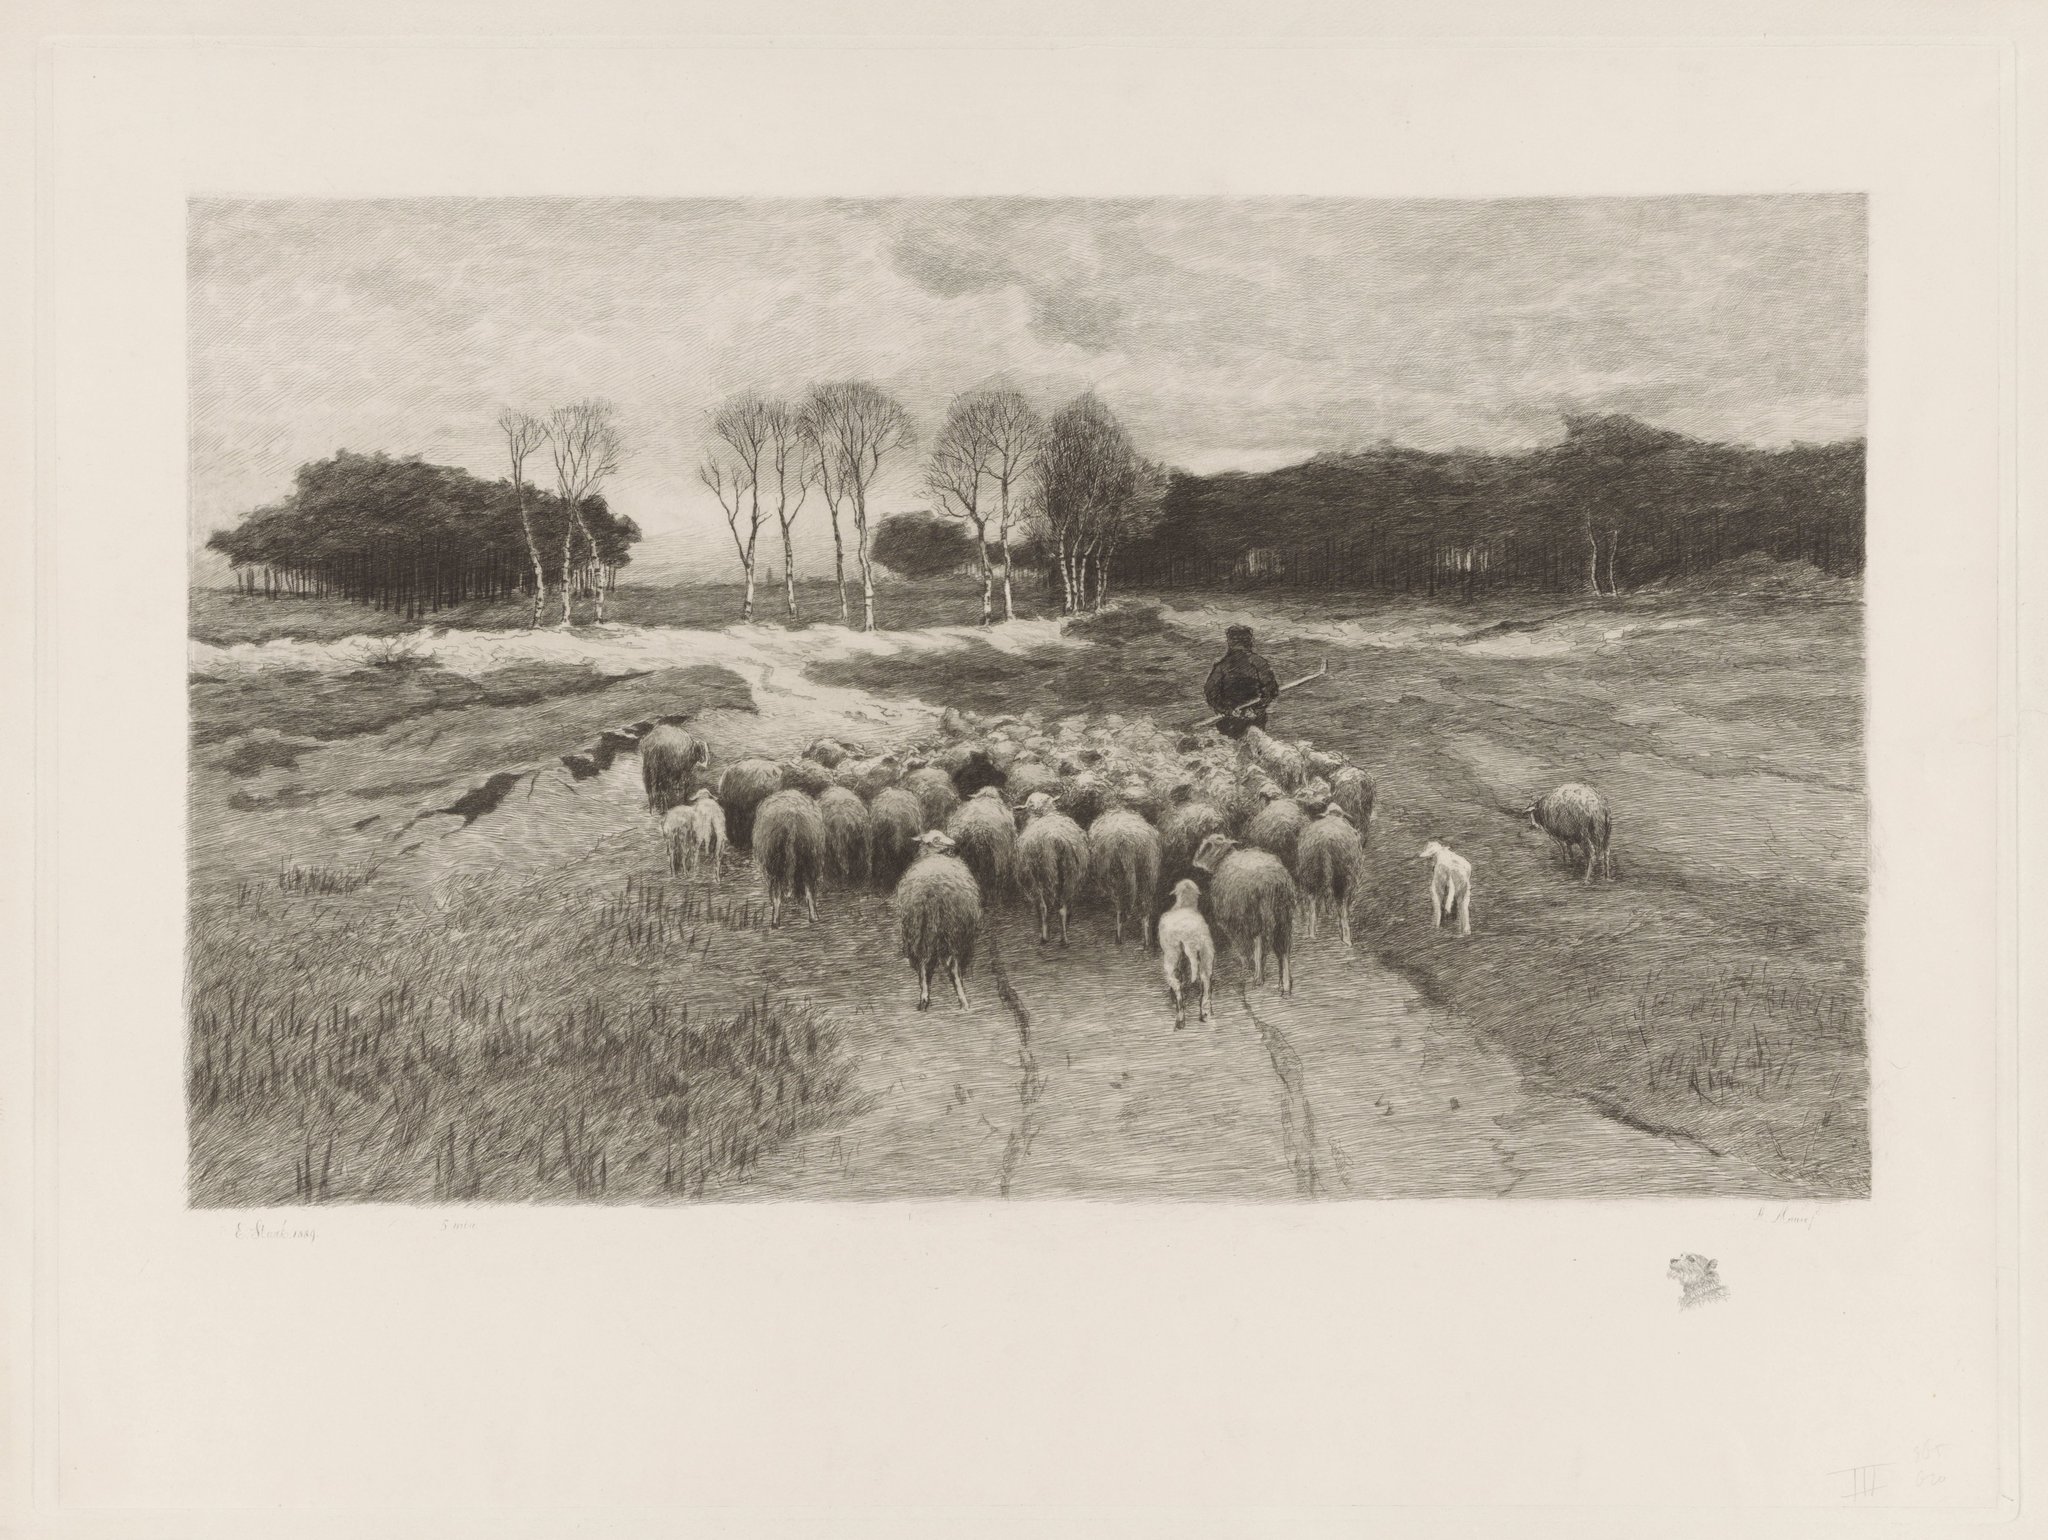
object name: print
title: Schaapherder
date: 1889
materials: paper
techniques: etching, intaglio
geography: nieuwer-amstel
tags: herding, herdsman, herdswoman, shepherd, shepherdess, cowherd, etc., sheep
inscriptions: collector's mark: Lugt 2228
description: Een schaapherder gevolgd door zijn kudde op de heide. Op de achtergrond berken en een bos. Rechtsonder in de marge een hondenkop.